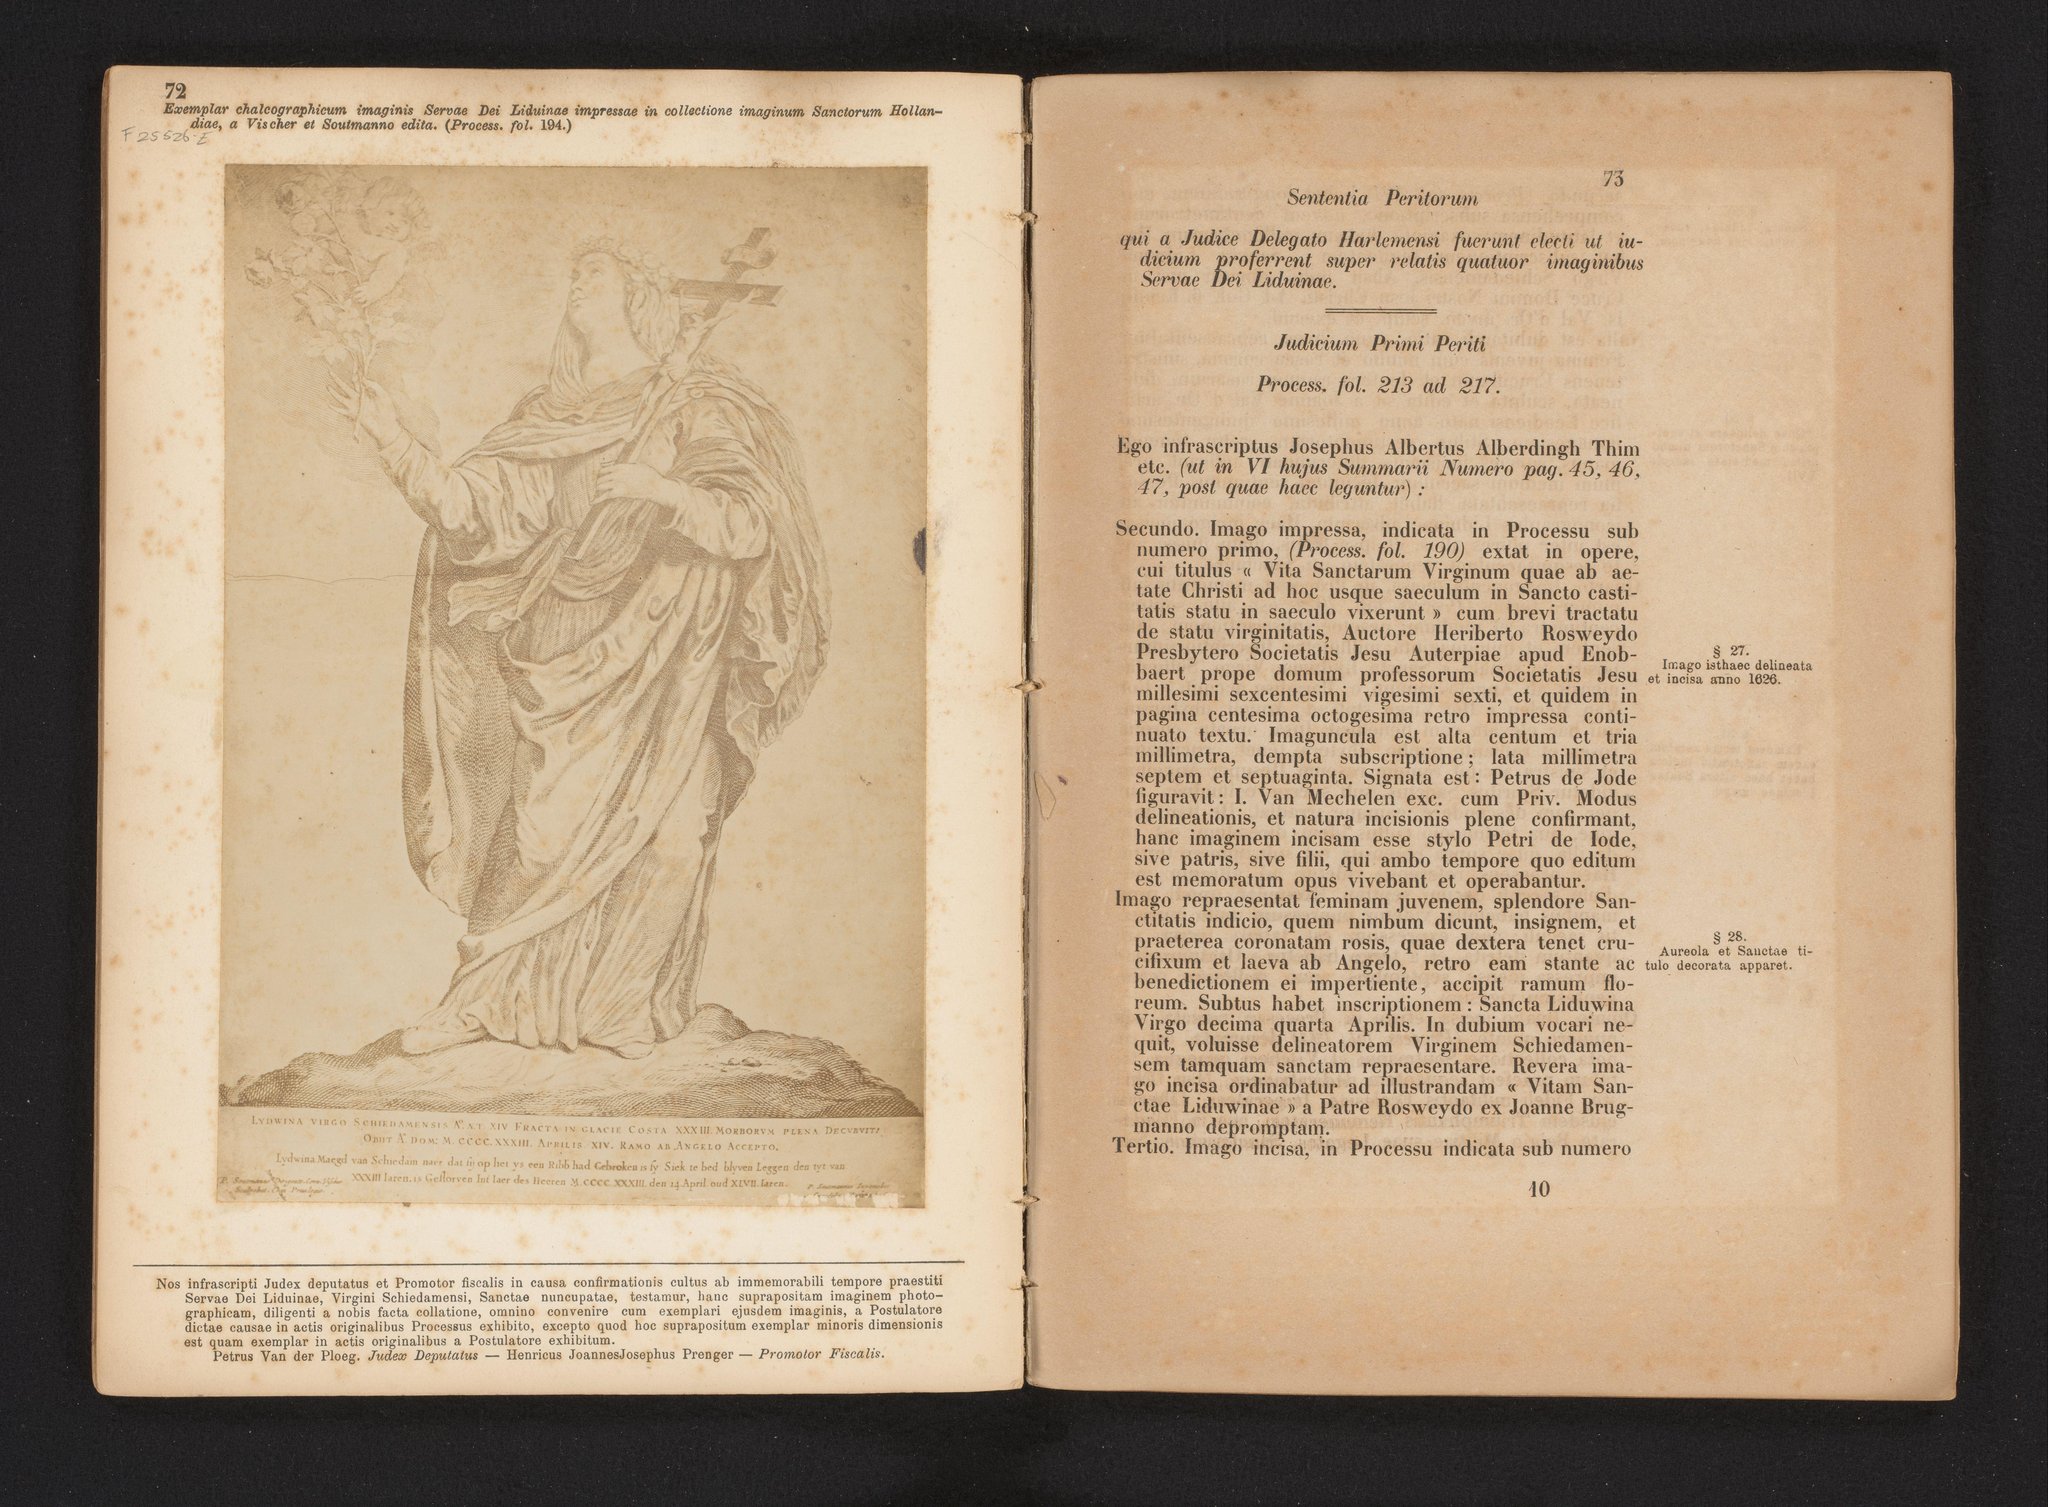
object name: page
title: Fotoreproductie van een gravure van Liduina van Schiedam met crucifix en rozentak door Cornelis Visscher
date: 1856-1877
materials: paper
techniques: albumen print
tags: the virgin lidwyna (lydwine) of schiedam; possible attributes: crucifix, branch of roses in hand, roses in hair